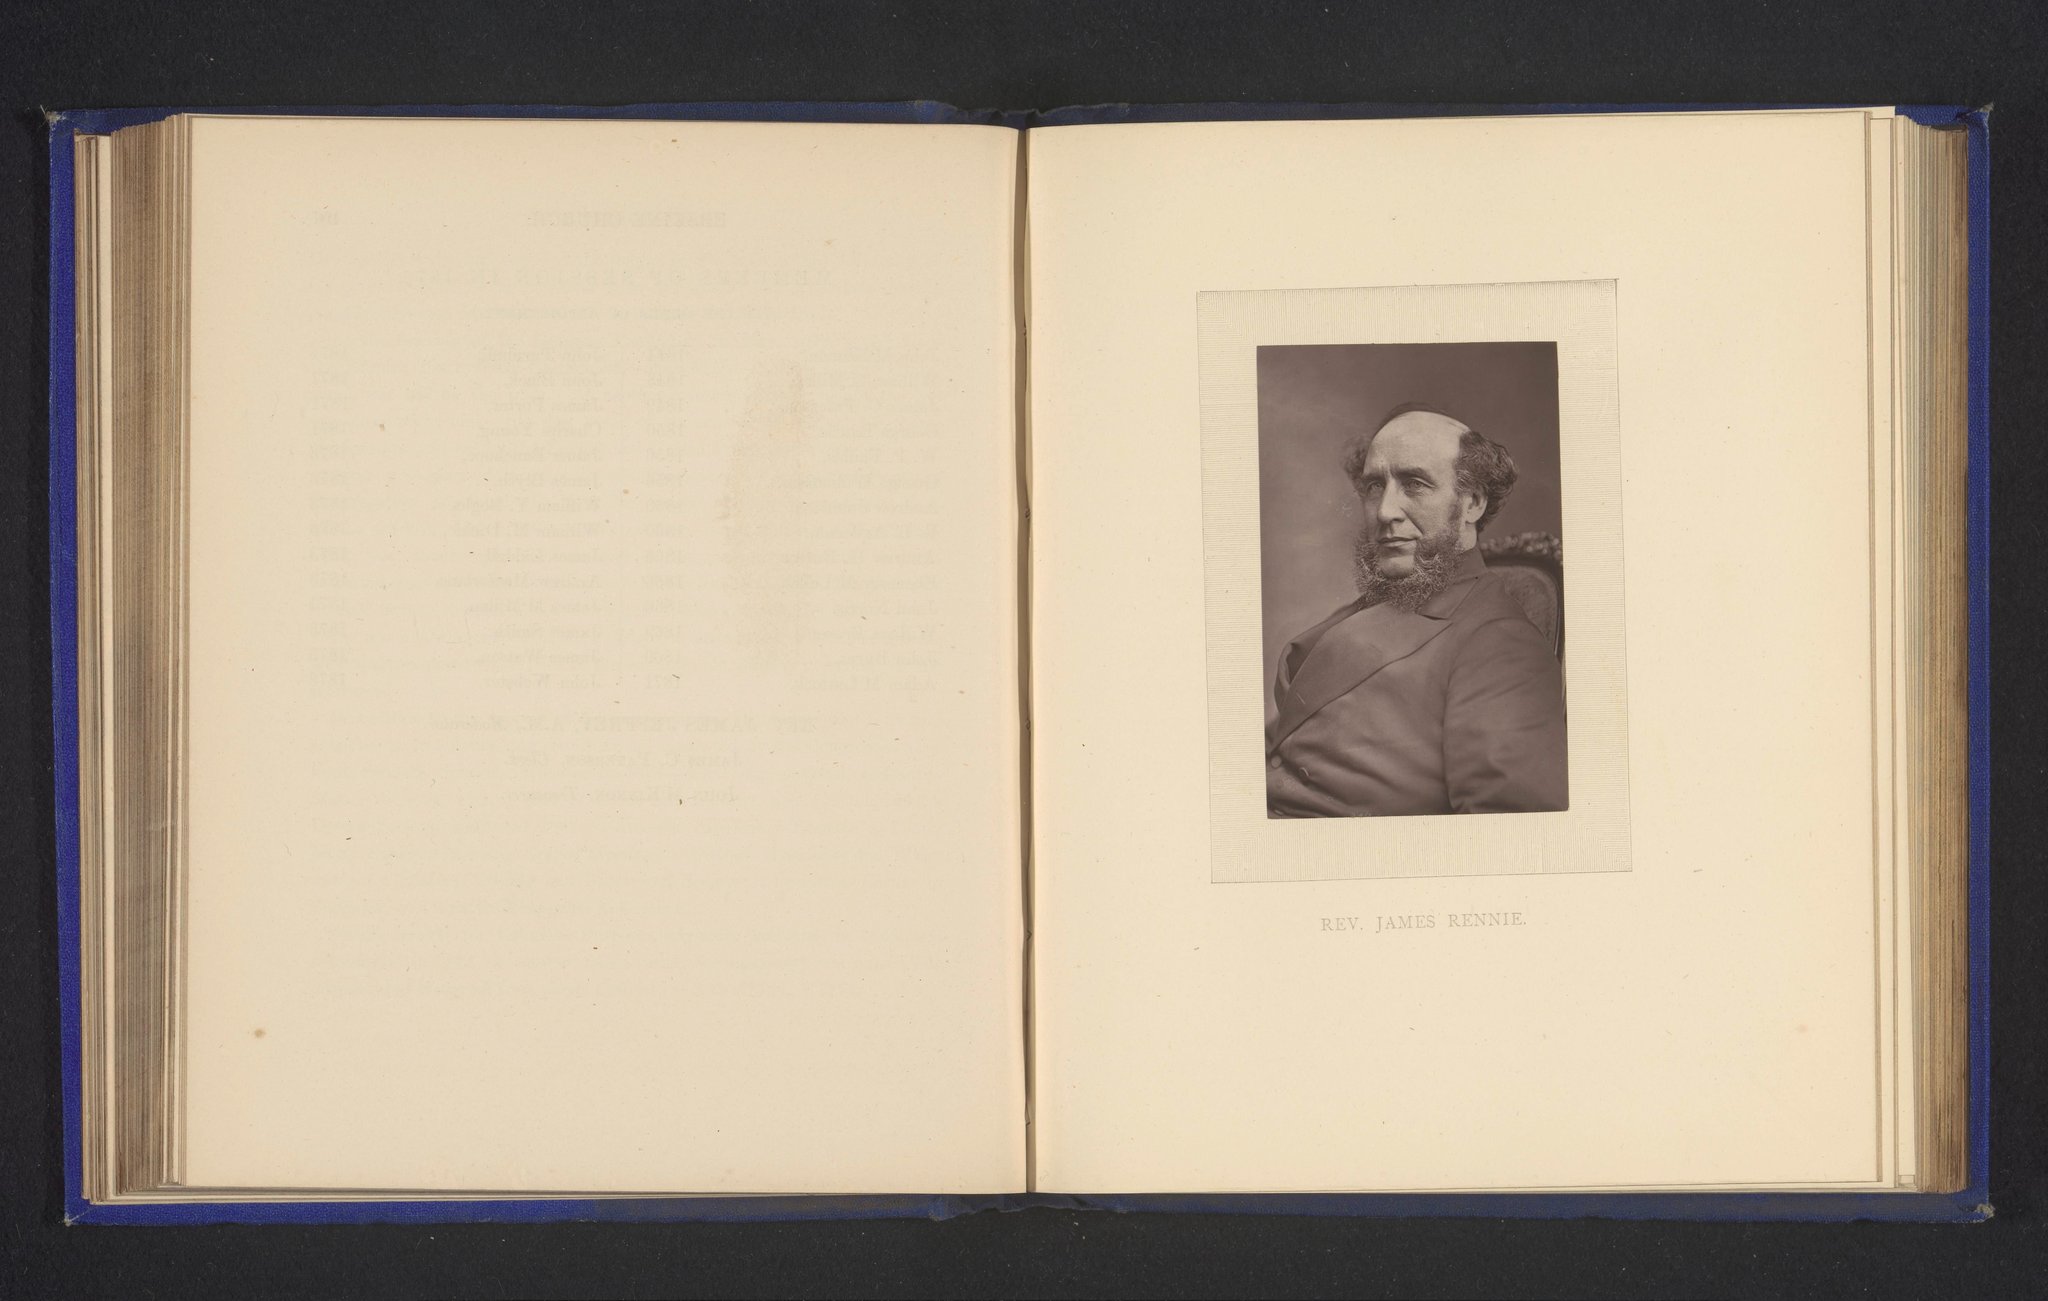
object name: page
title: Portret van James Rennie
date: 1865-1875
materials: paper, photographic support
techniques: carbon print, woodburytype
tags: functionaries and dignitaries (with name) ~ protestant churches